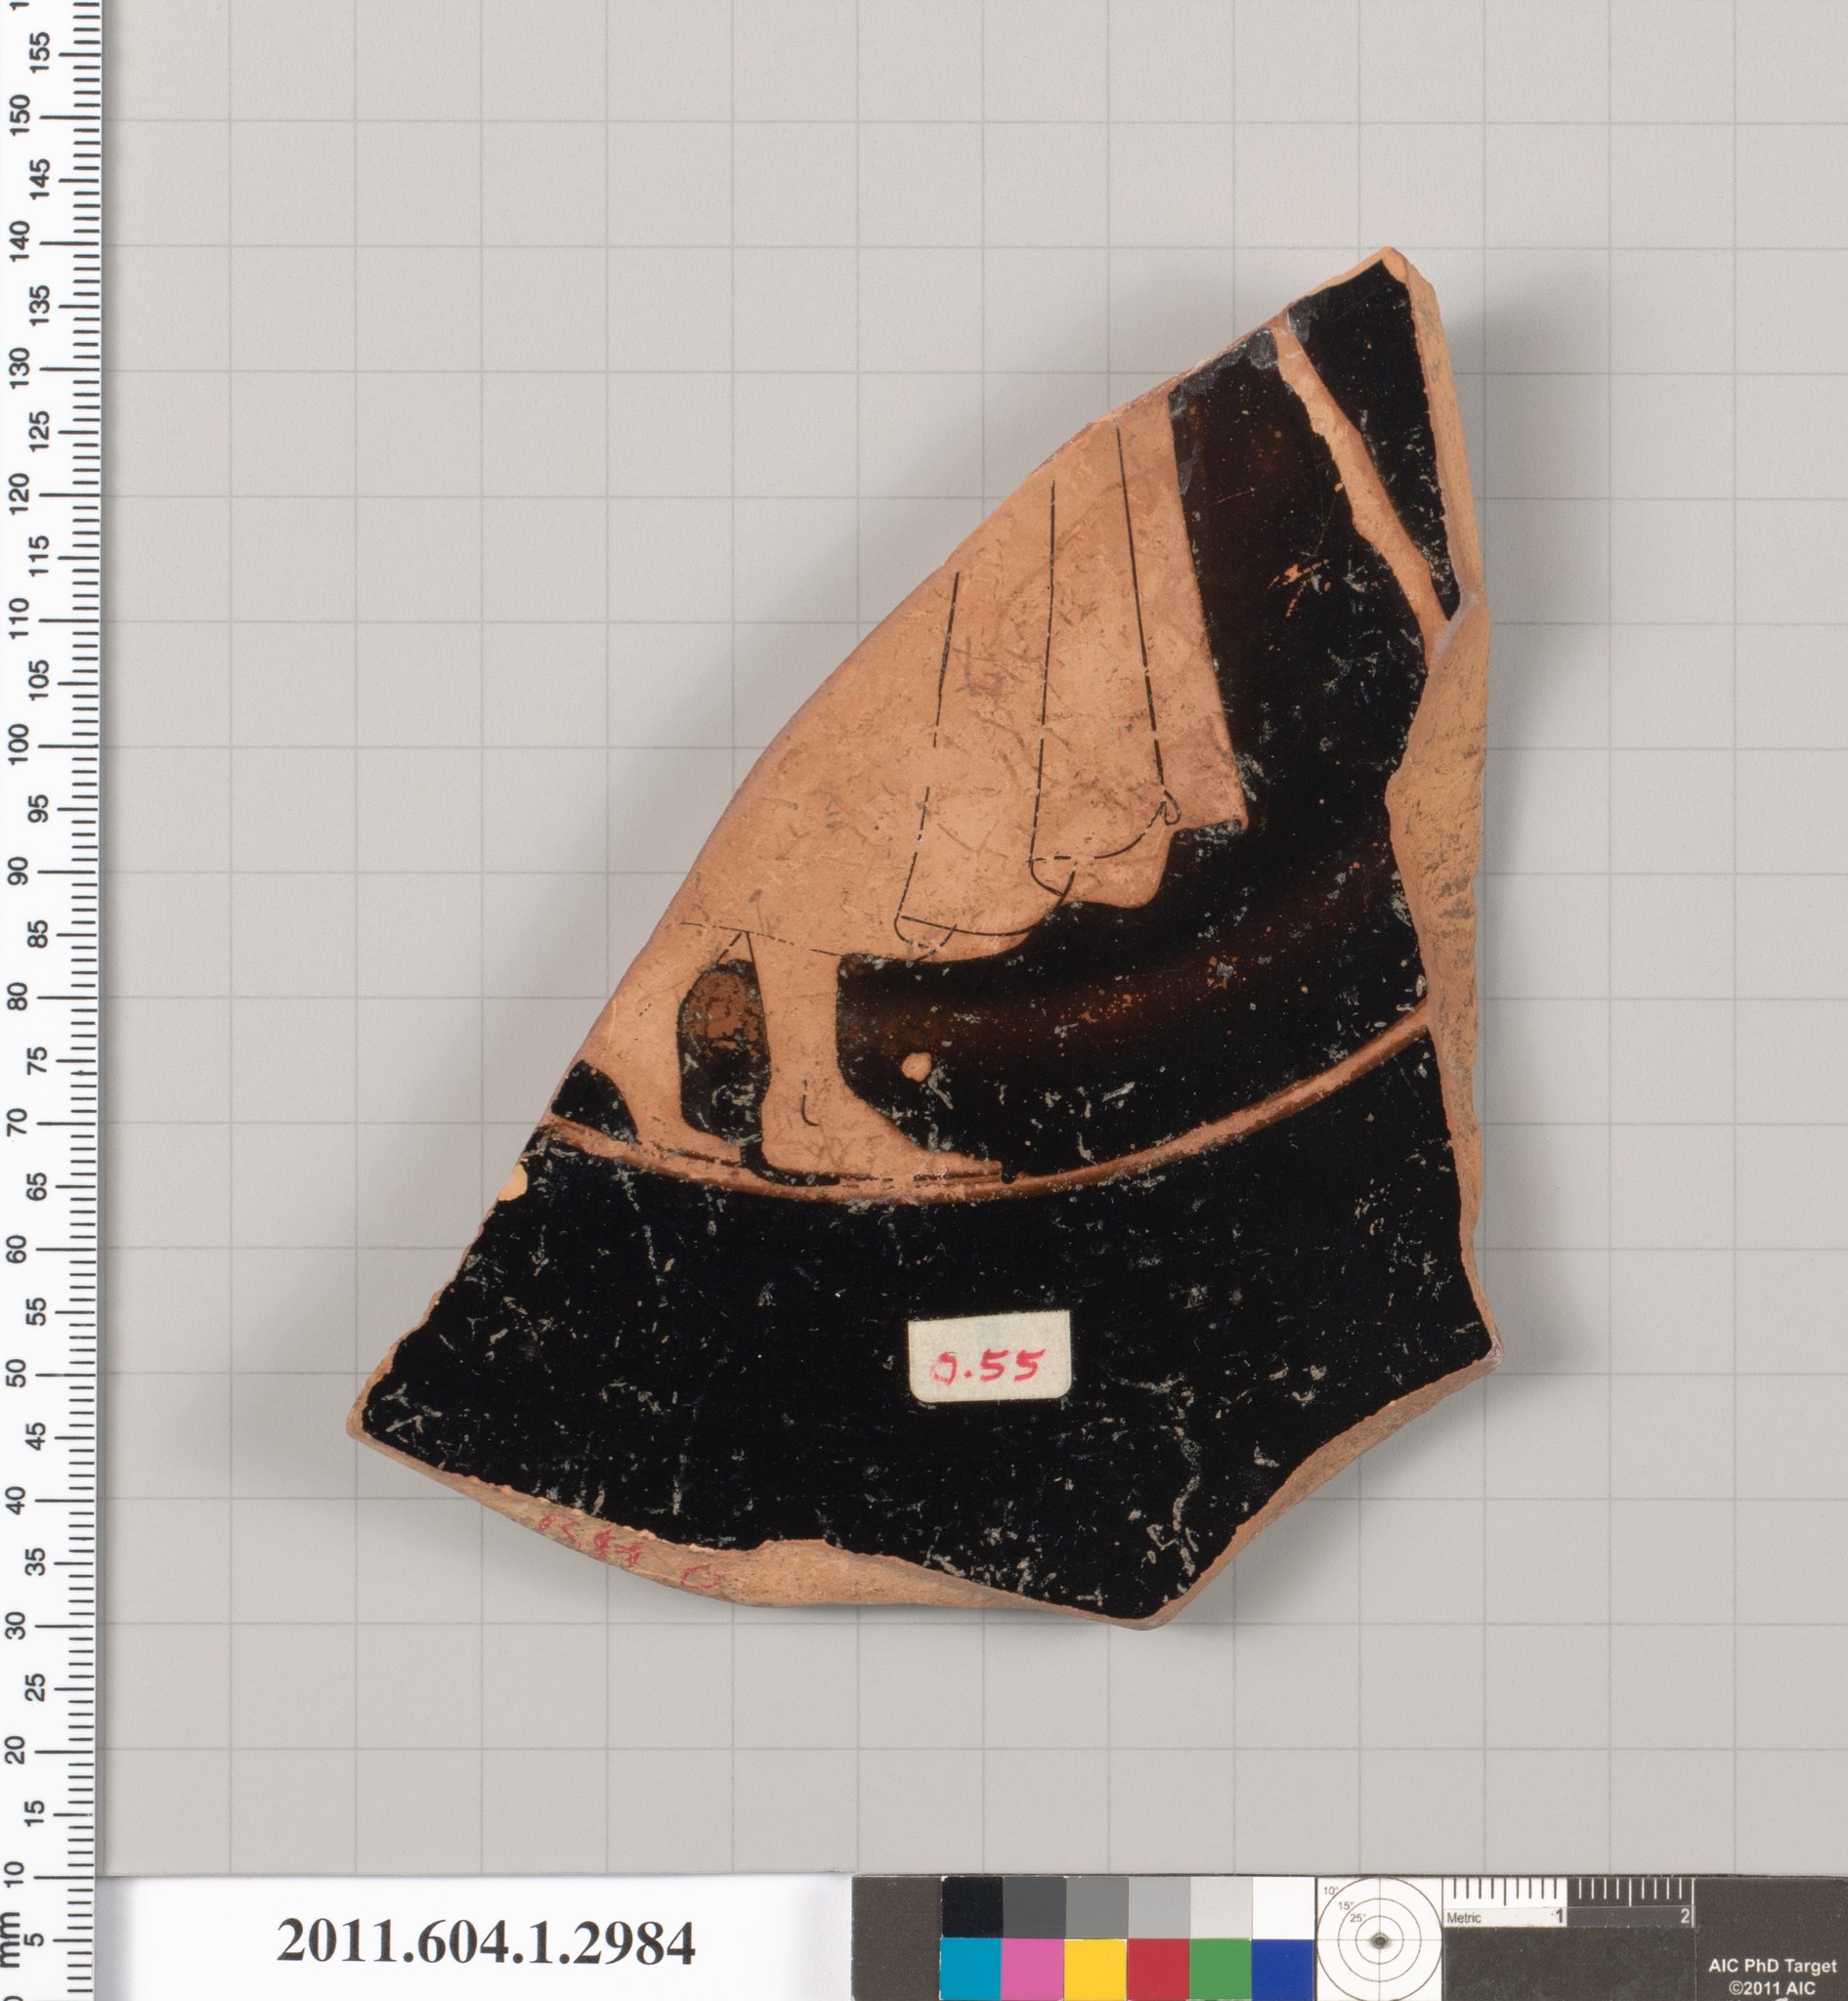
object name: kylix fragment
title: Terracotta fragment of a kylix (drinking cup)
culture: greek, attic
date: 520-500 BCE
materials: terracotta